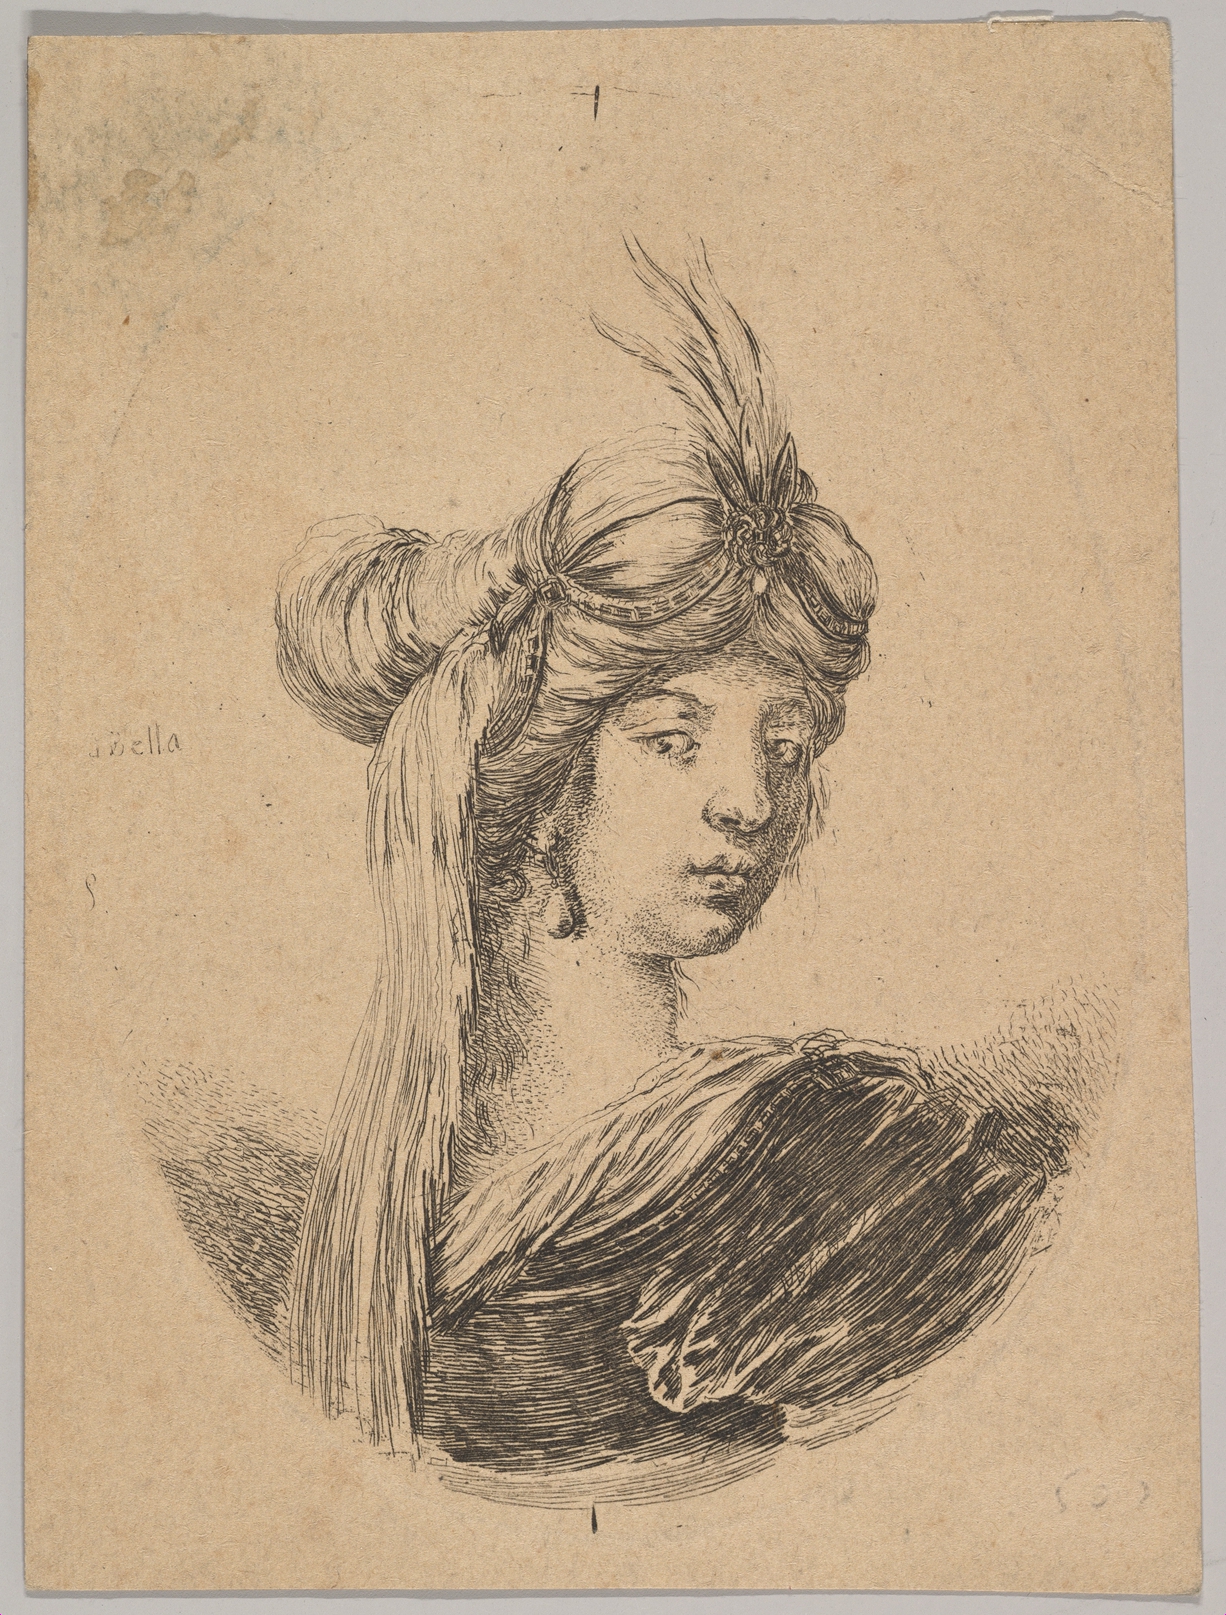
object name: print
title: A woman wearing an ornate turban with a veil, seen from behind and turned three-quarters to the right, from "Several heads in the Persian style" (Plusieurs têtes coiffées à la persienne)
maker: stefano della bella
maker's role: artist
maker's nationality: italian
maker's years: 1610-1664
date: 1650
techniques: etching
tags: portraits,women,fashion